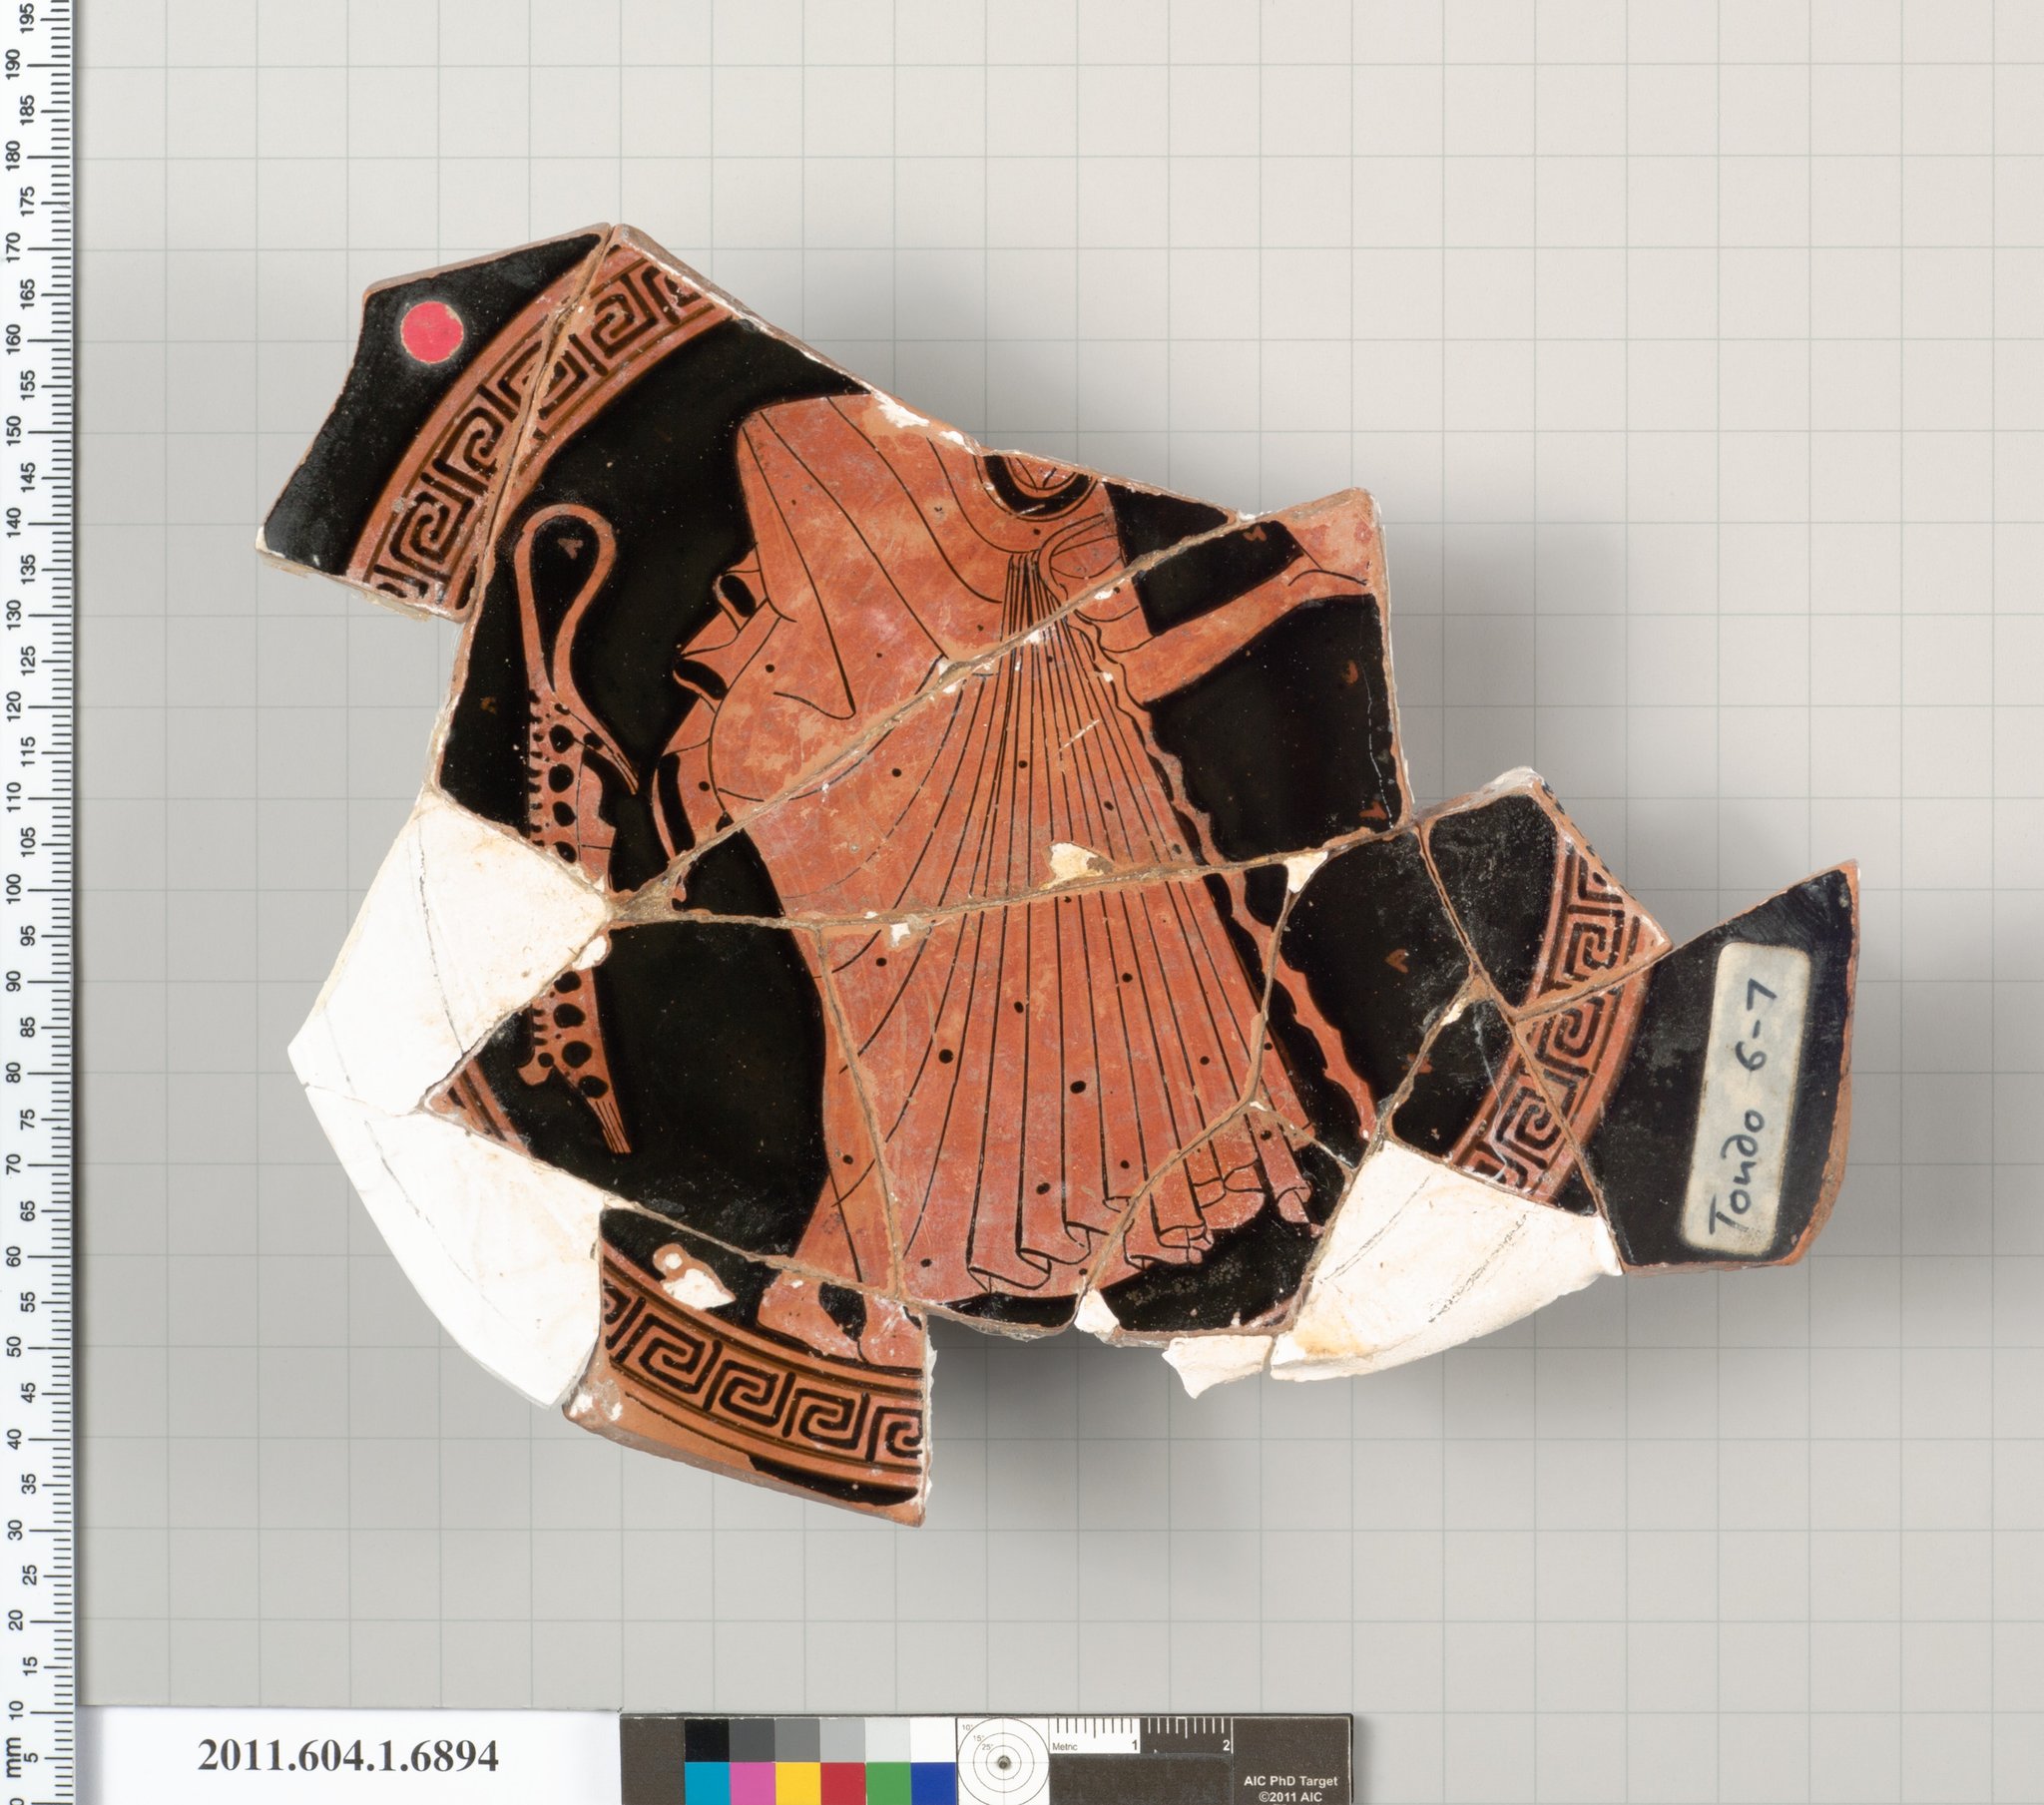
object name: kylix fragment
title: Terracotta fragment of a kylix (drinking cup)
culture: greek, attic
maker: brygos painter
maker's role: artist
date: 490-470 BCE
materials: terracotta